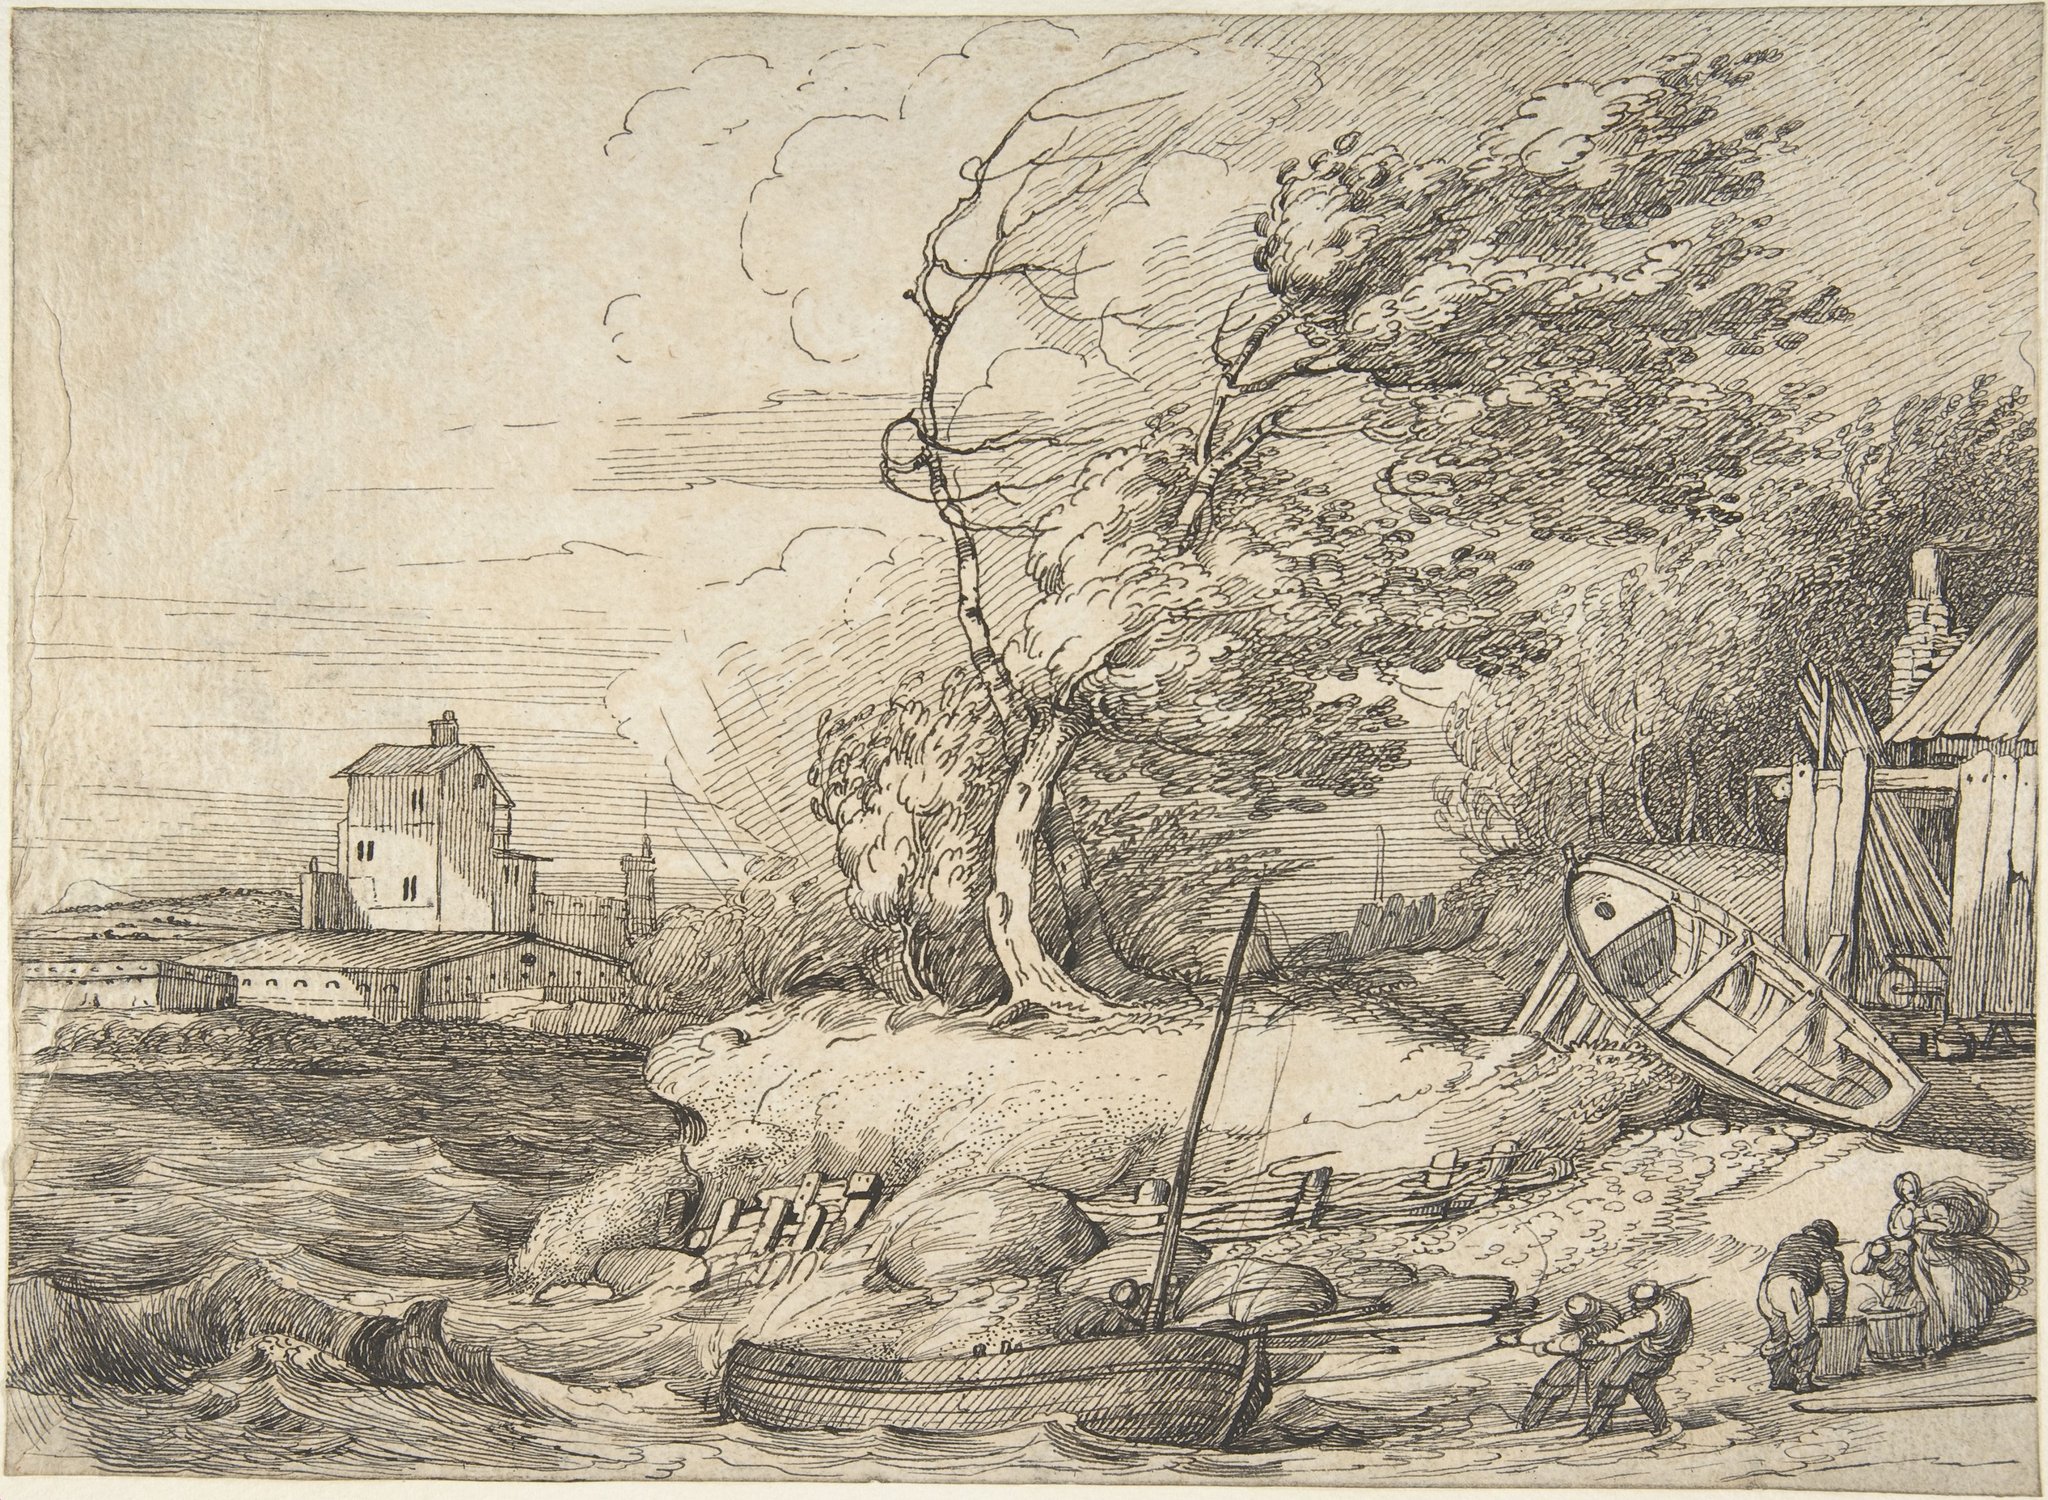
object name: drawing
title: Beaching a Fishing Boat in a Gale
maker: john hamilton mortimer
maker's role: artist and publisher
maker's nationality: british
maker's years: 1740-1779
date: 1770-1779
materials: ink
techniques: pen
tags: landscapes,boats